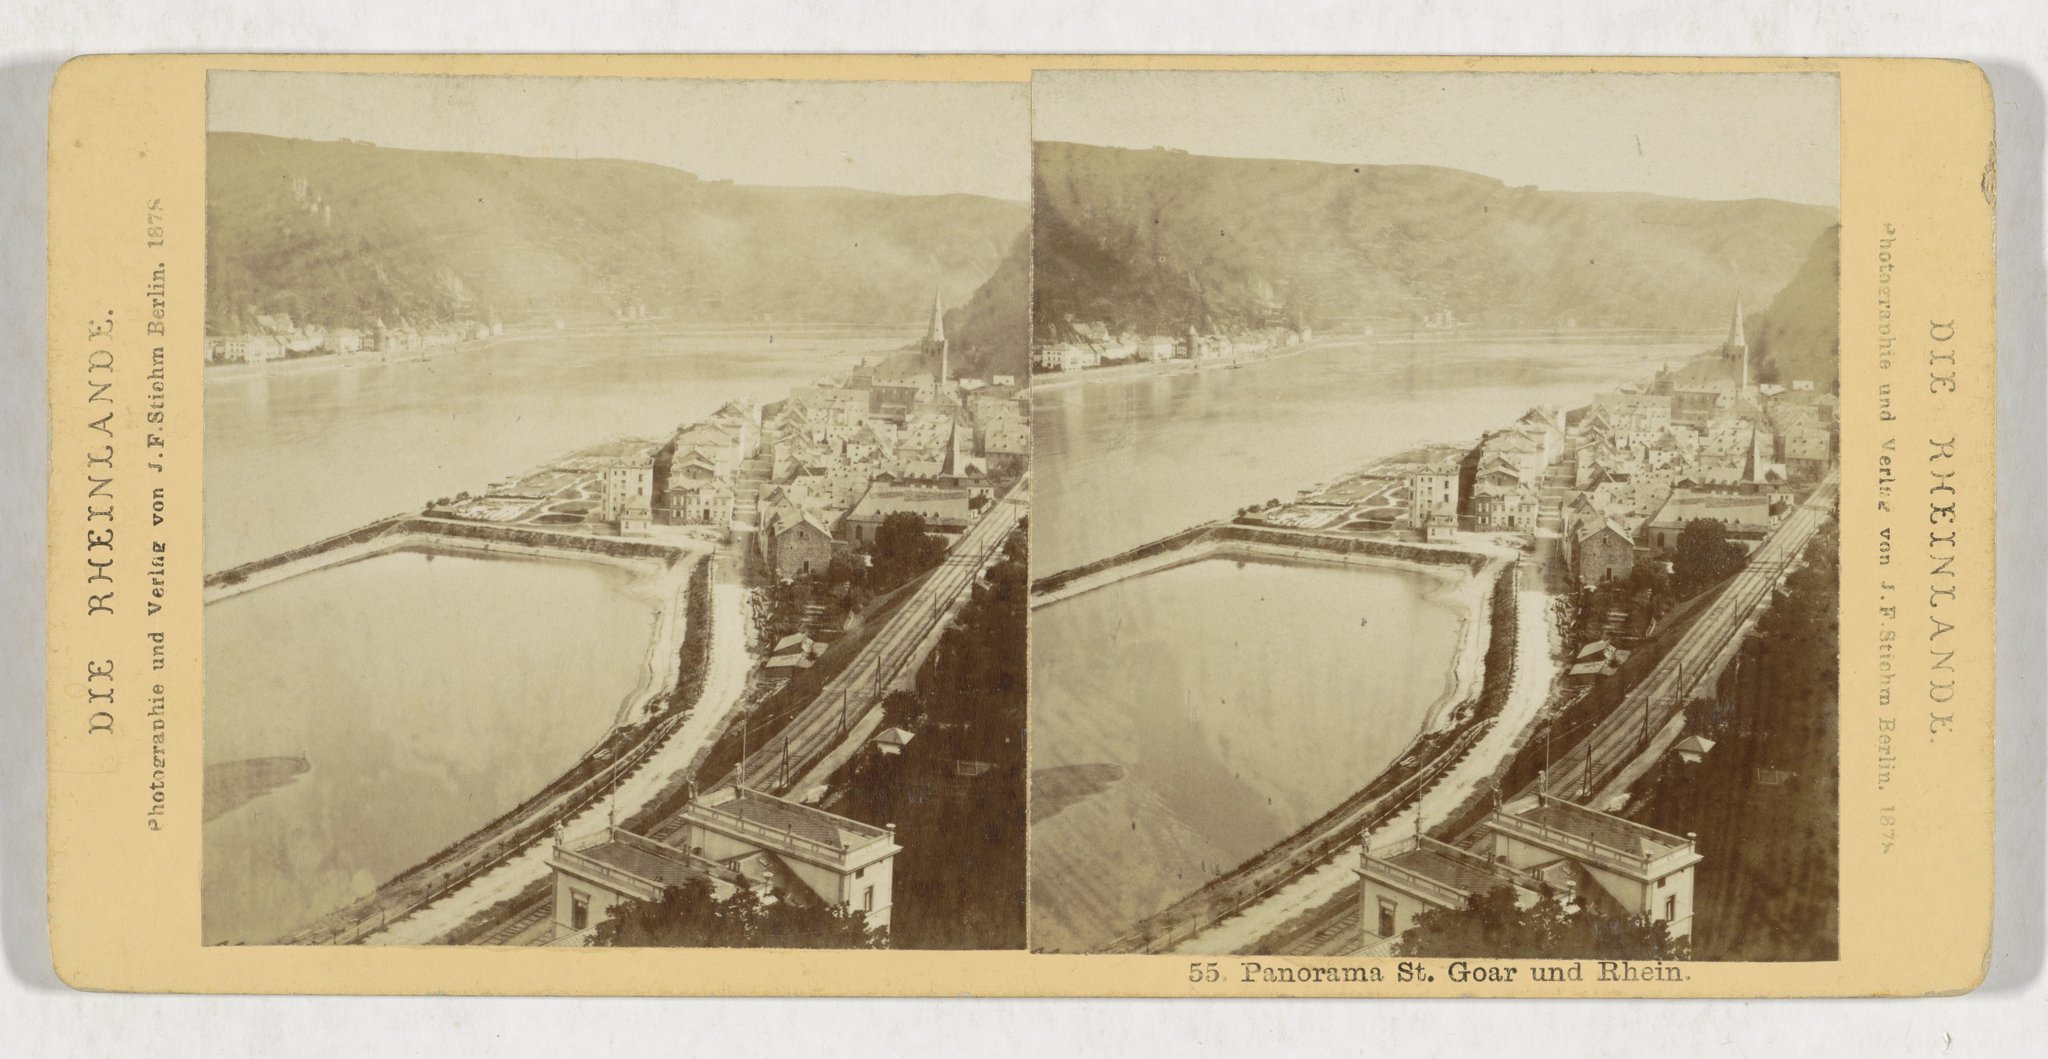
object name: stereograph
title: Panorama St. Goar und Rhein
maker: johann friedrich stiehm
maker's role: fotograaf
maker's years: 1826-1902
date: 1878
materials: cardboard, paper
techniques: albumen print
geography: berlin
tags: city-view in general; 'veduta', river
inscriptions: inscription: ‘04’, number: ‘55.’